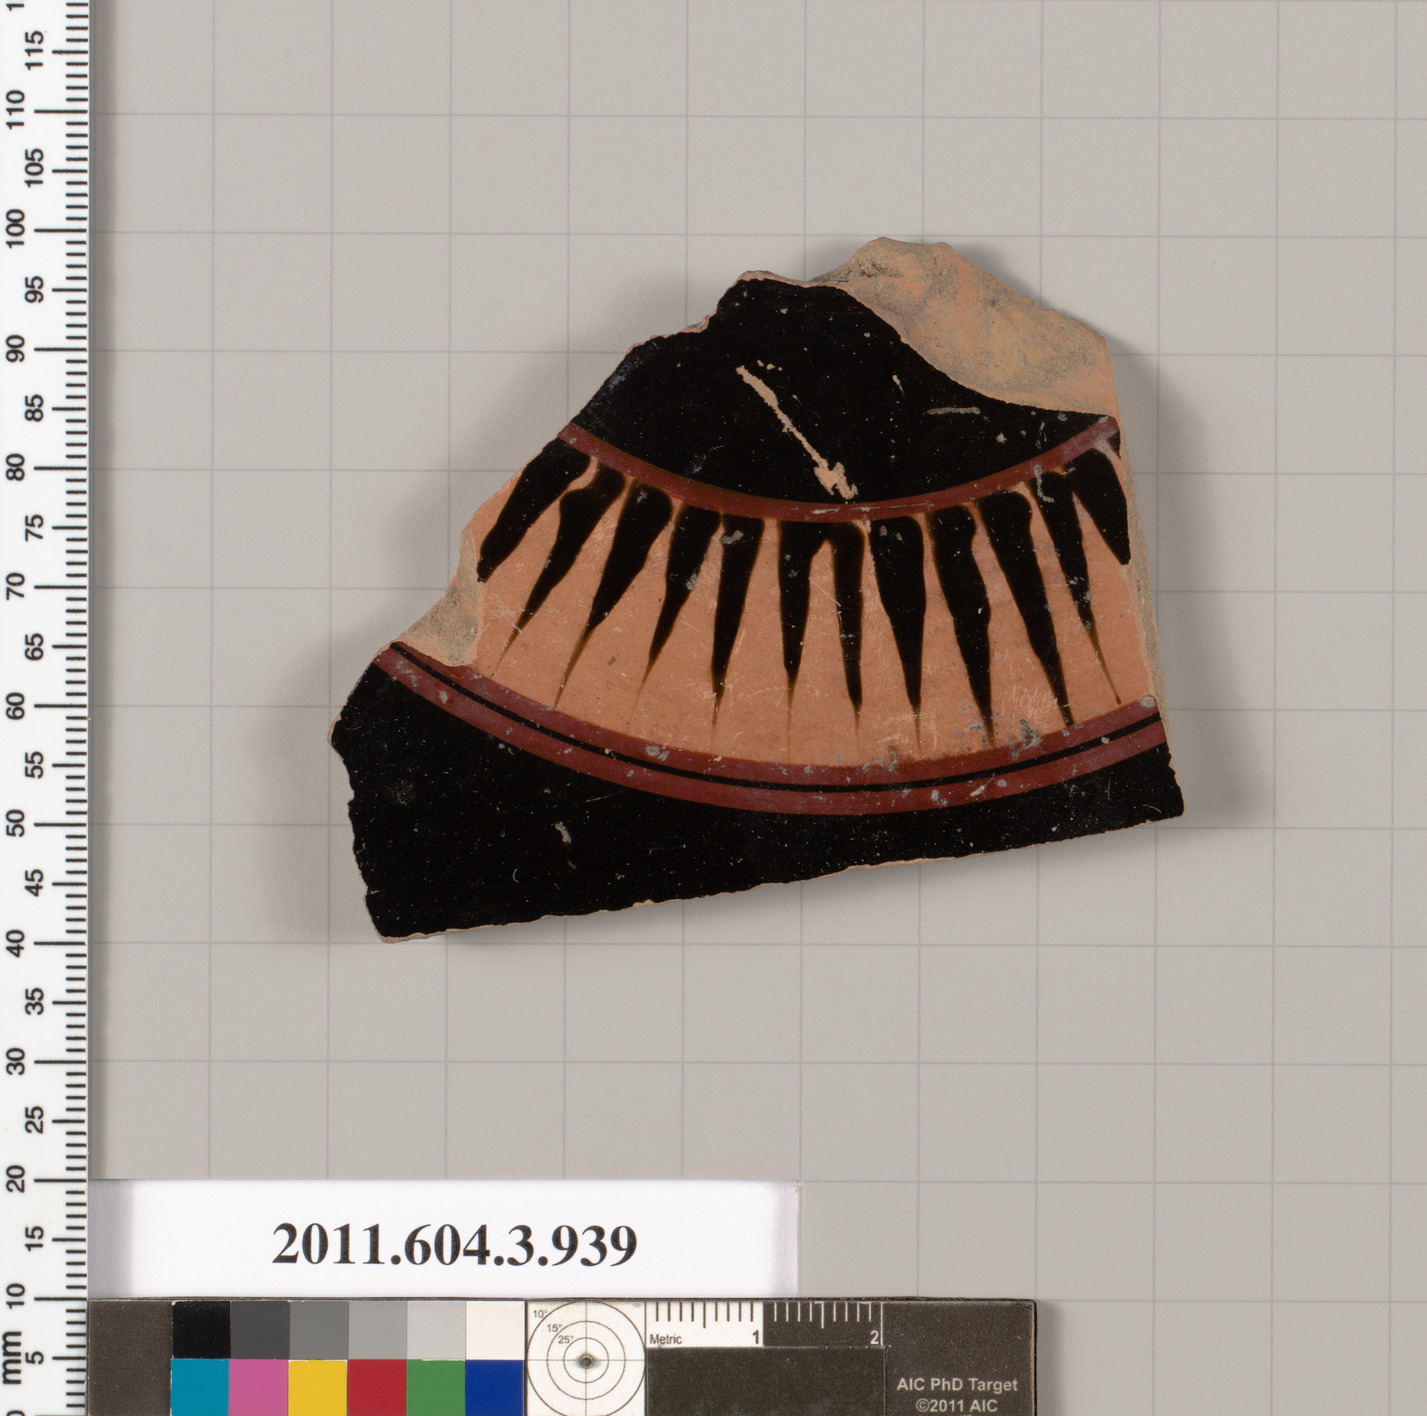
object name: lekanis lid fragment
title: Terracotta fragment of a lekanis lid (covered dish)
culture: greek, attic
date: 600-501 BCE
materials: terracotta